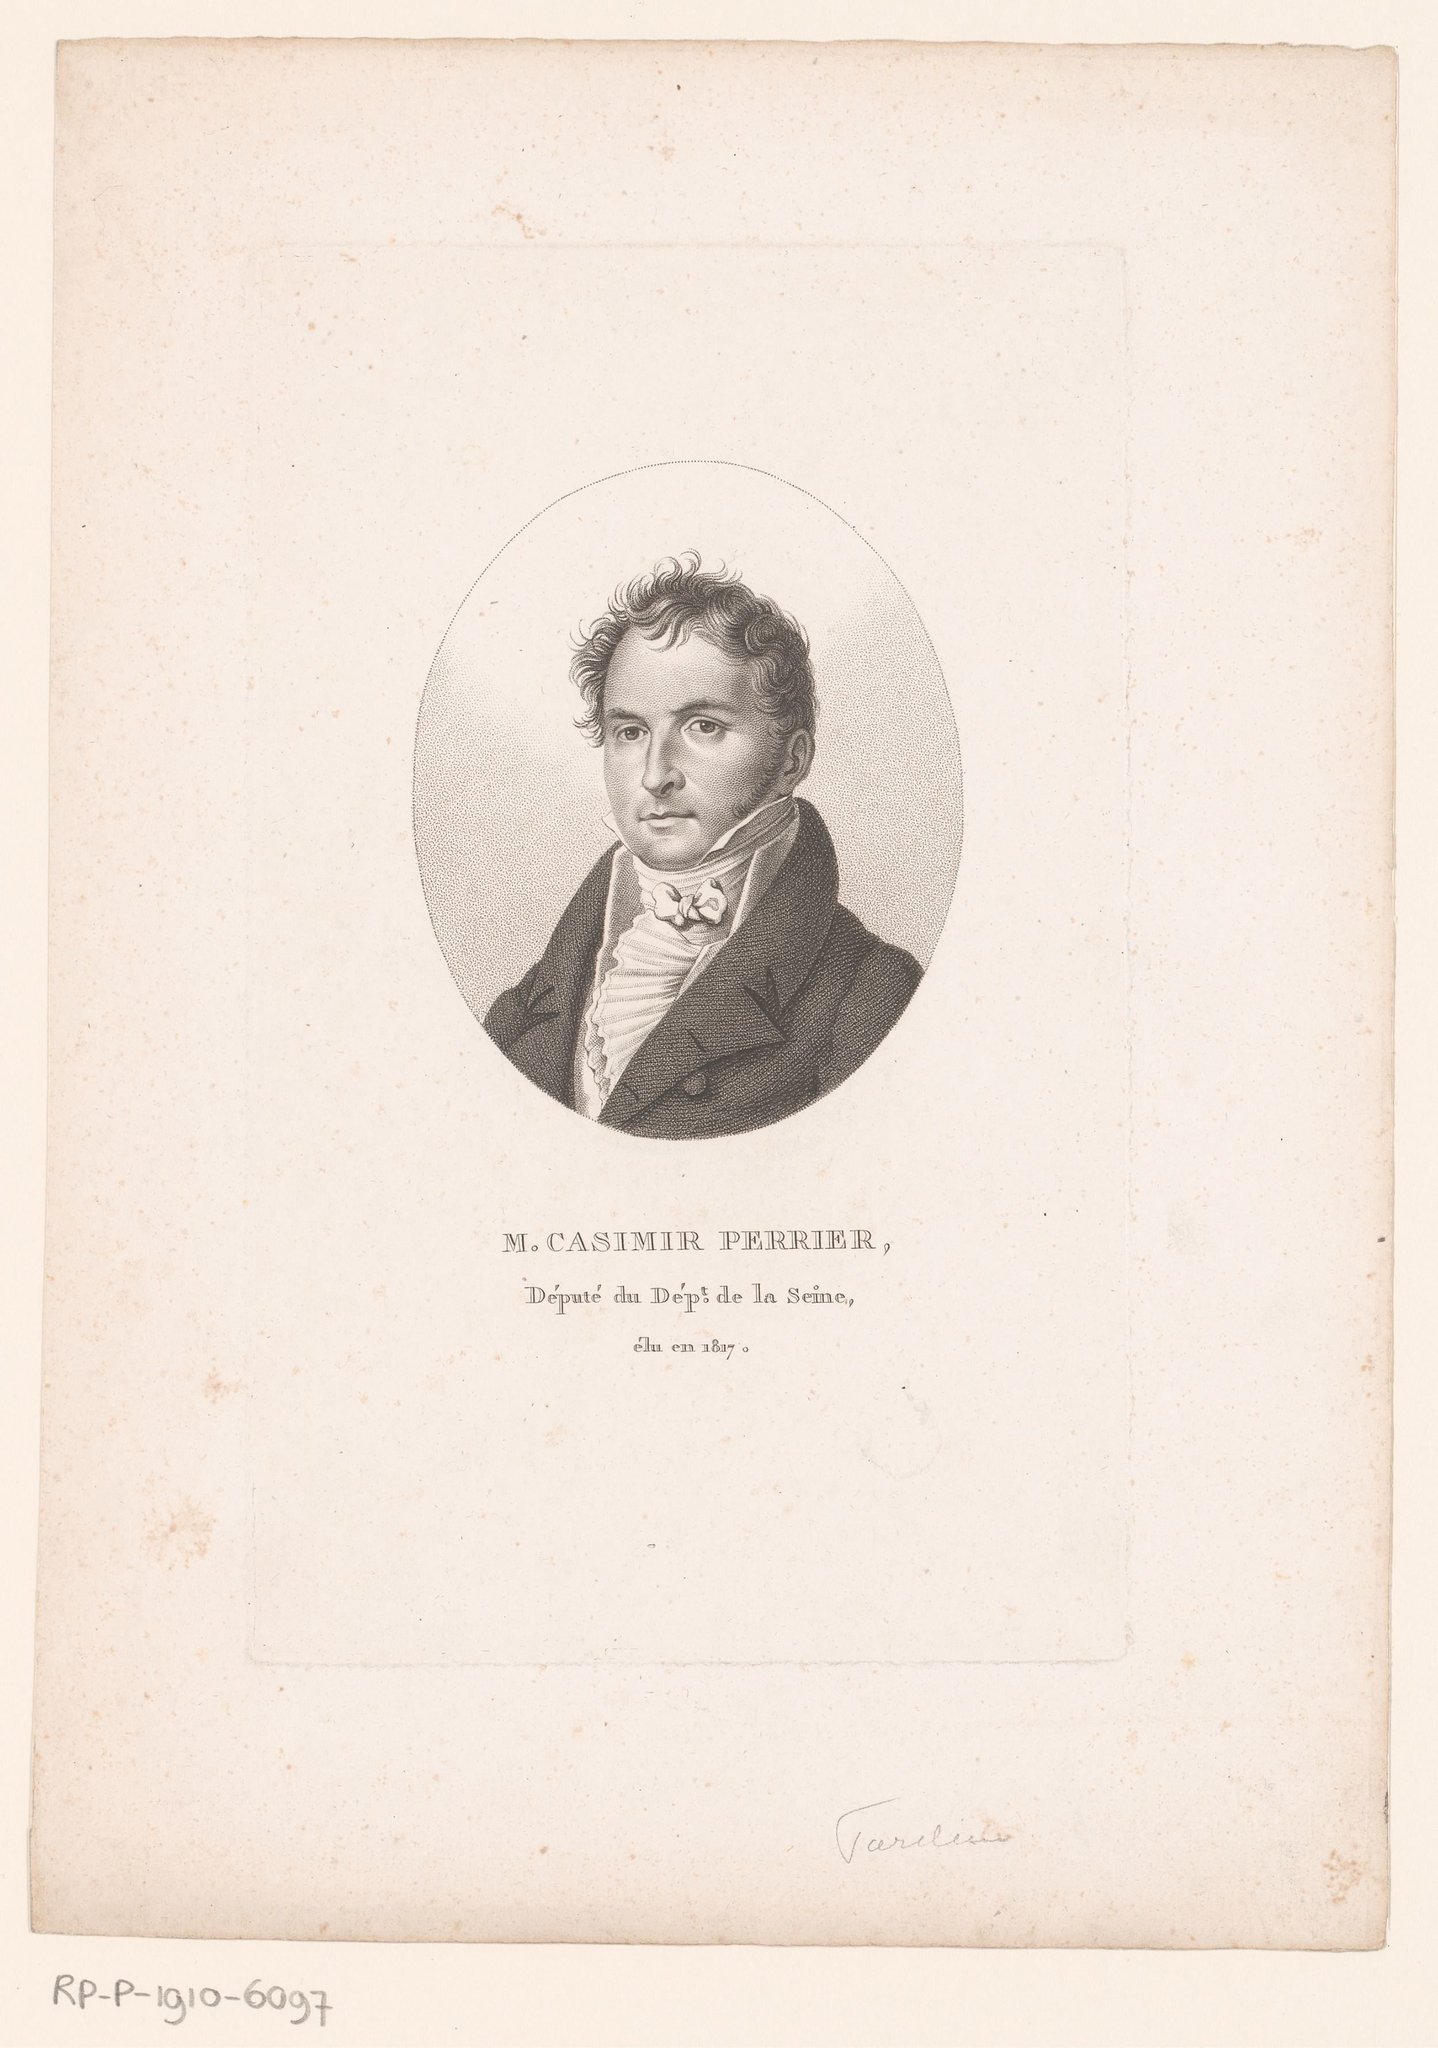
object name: print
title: Portret van Casimir-Pierre Périer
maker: ambroise tardieu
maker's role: print maker, printer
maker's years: 1788-1841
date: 1820-1821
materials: paper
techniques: engraving, roulette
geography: paris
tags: politician, historical persons, politician, e.g. party leader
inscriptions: collector's mark: Lugt 2228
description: Prent uit: Tardieu, Ambroise. Portraits des députés, écrivains et pairs constitutionnels, défenseurs invariables de la charte et de la loi des élections du 5 février 1817. Parijs: Tardieu, Ambroise, 1820-1821.